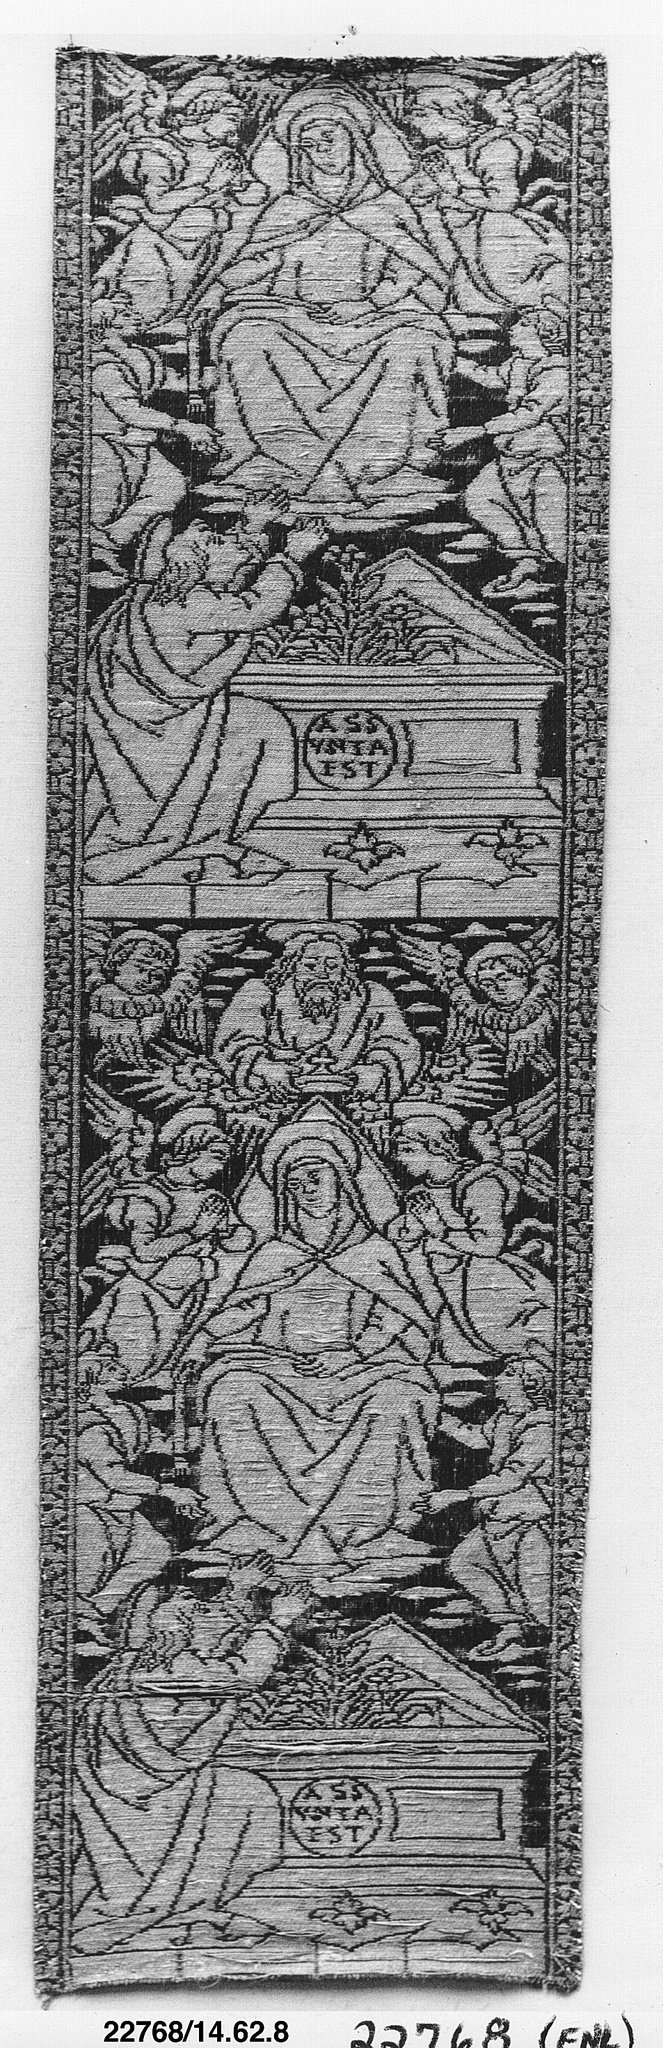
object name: orphrey fragment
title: Part of an orphrey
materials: linen, metal thread, silk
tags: angels,virgin mary